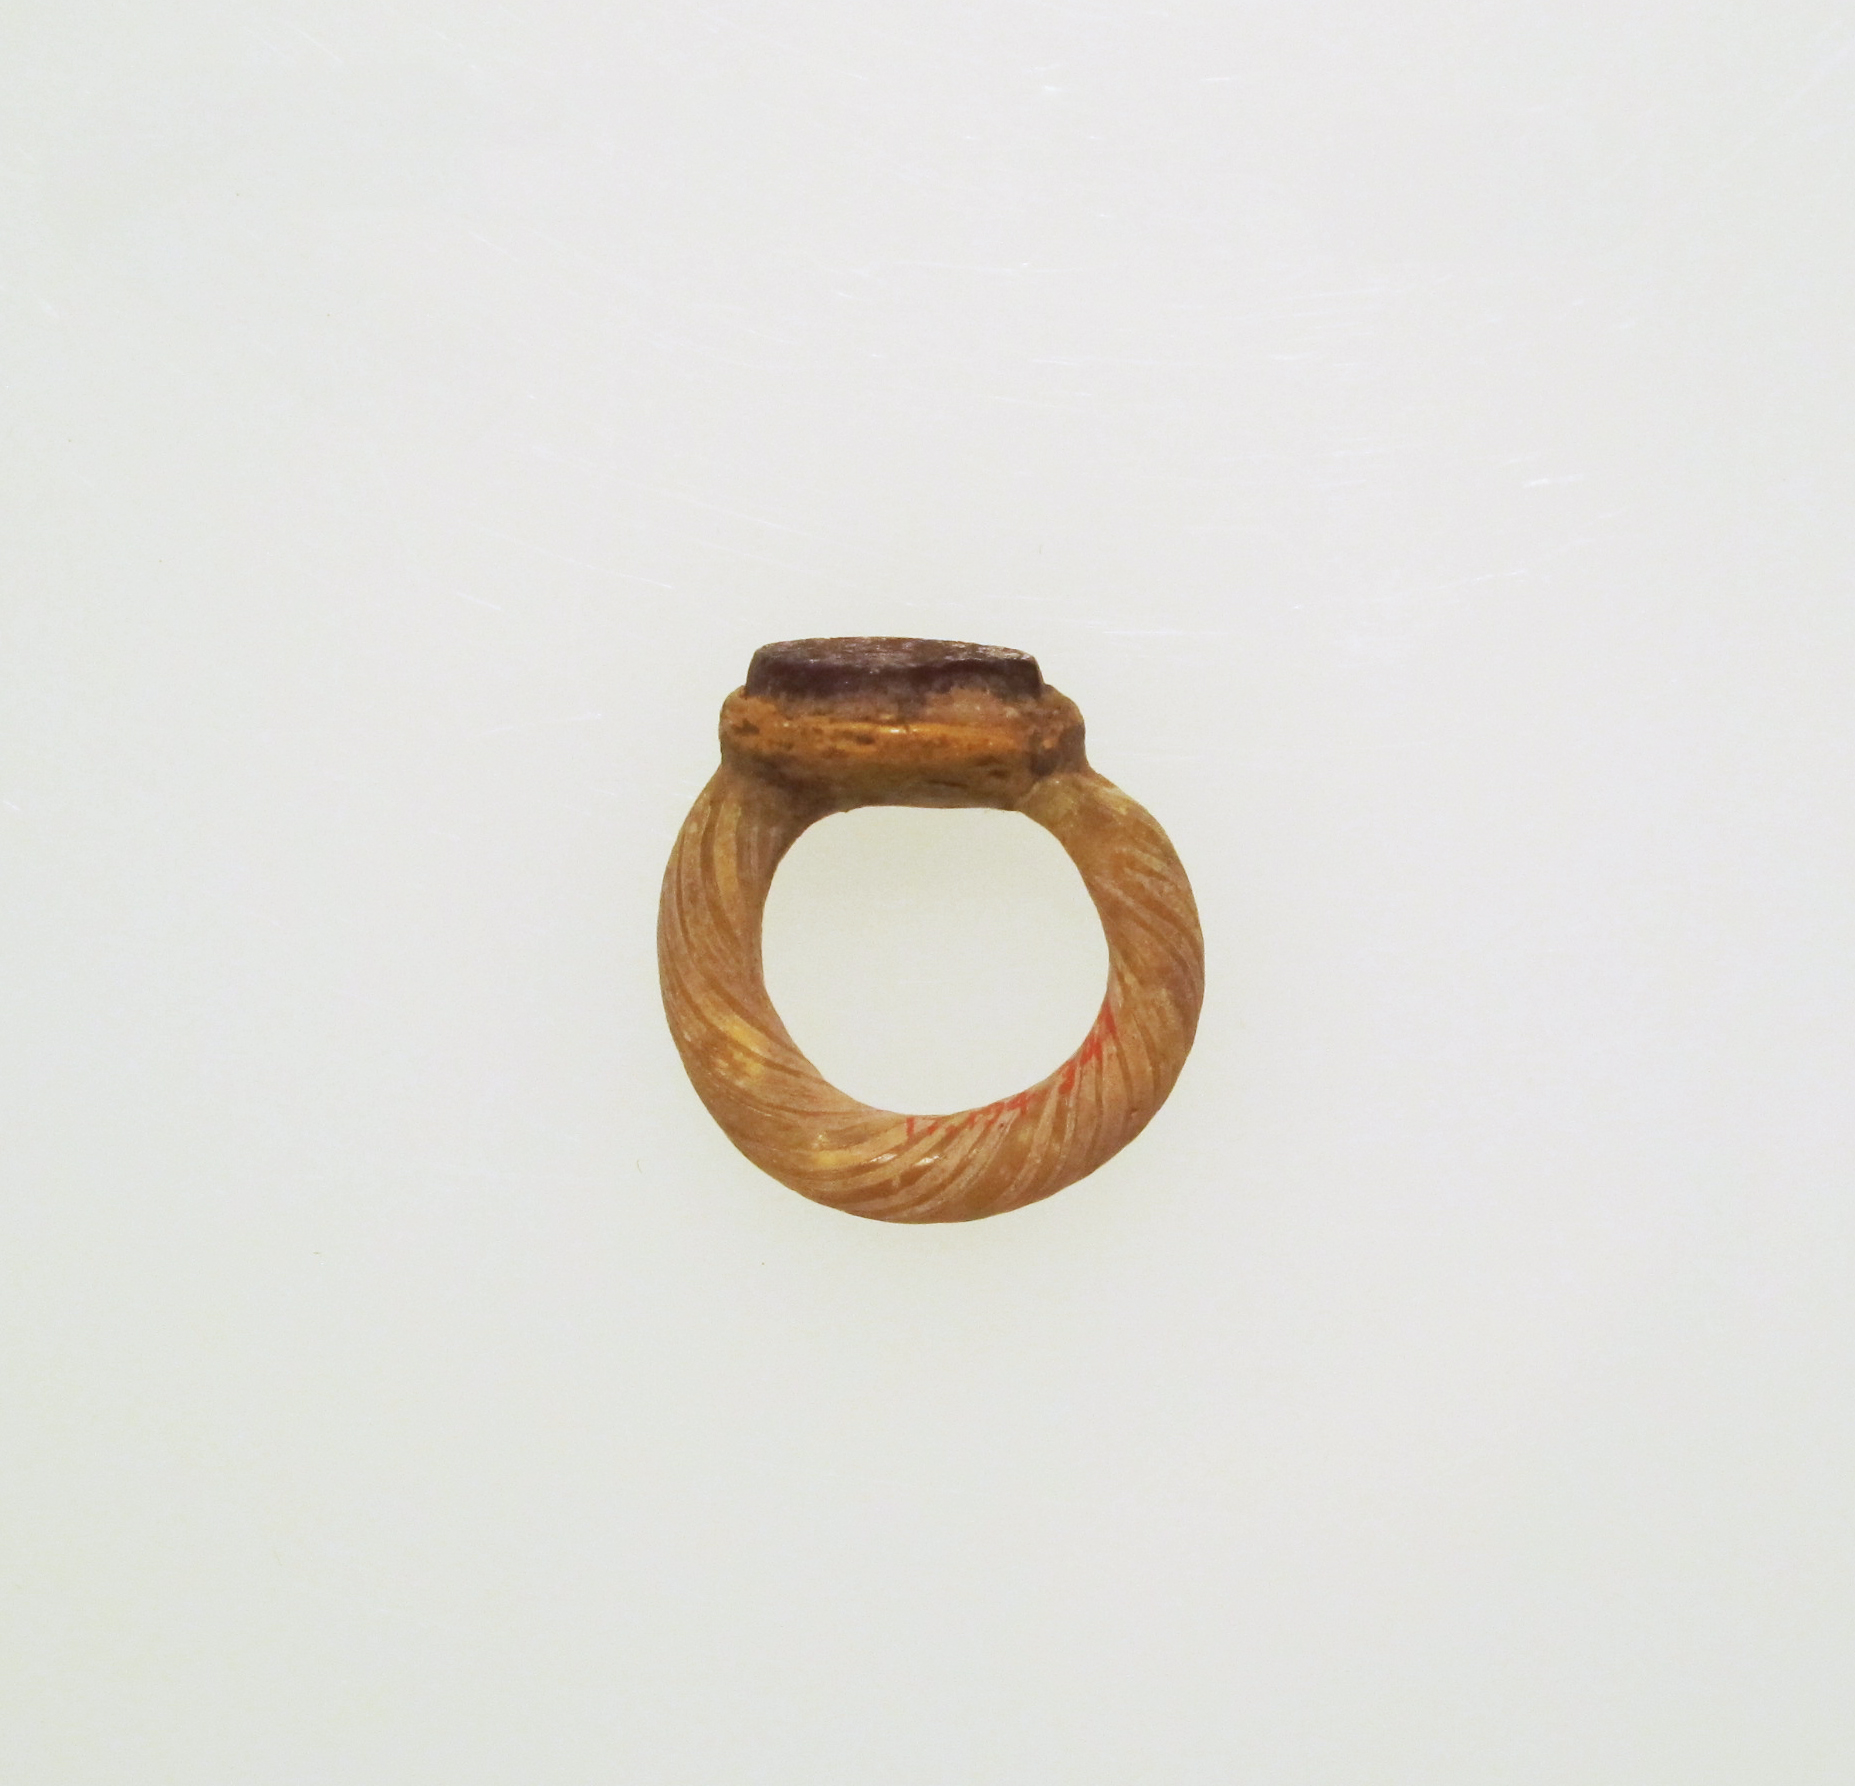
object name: ring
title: Glass finger ring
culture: roman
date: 1-100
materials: glass